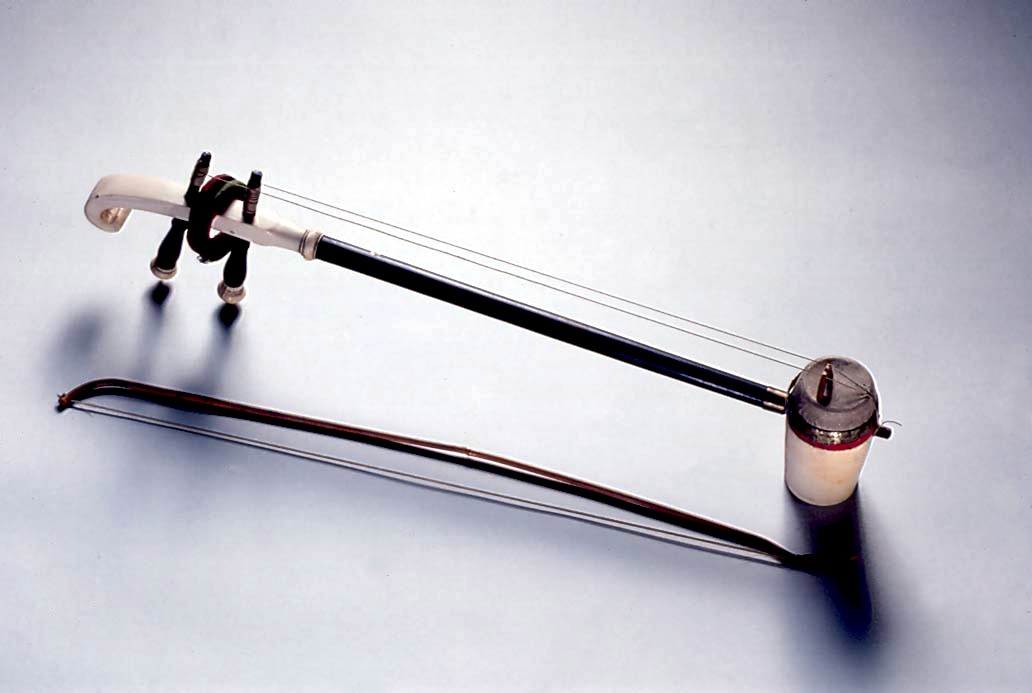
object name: saw duang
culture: thai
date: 1867-1900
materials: bone, ivory, metal, wood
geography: thailand